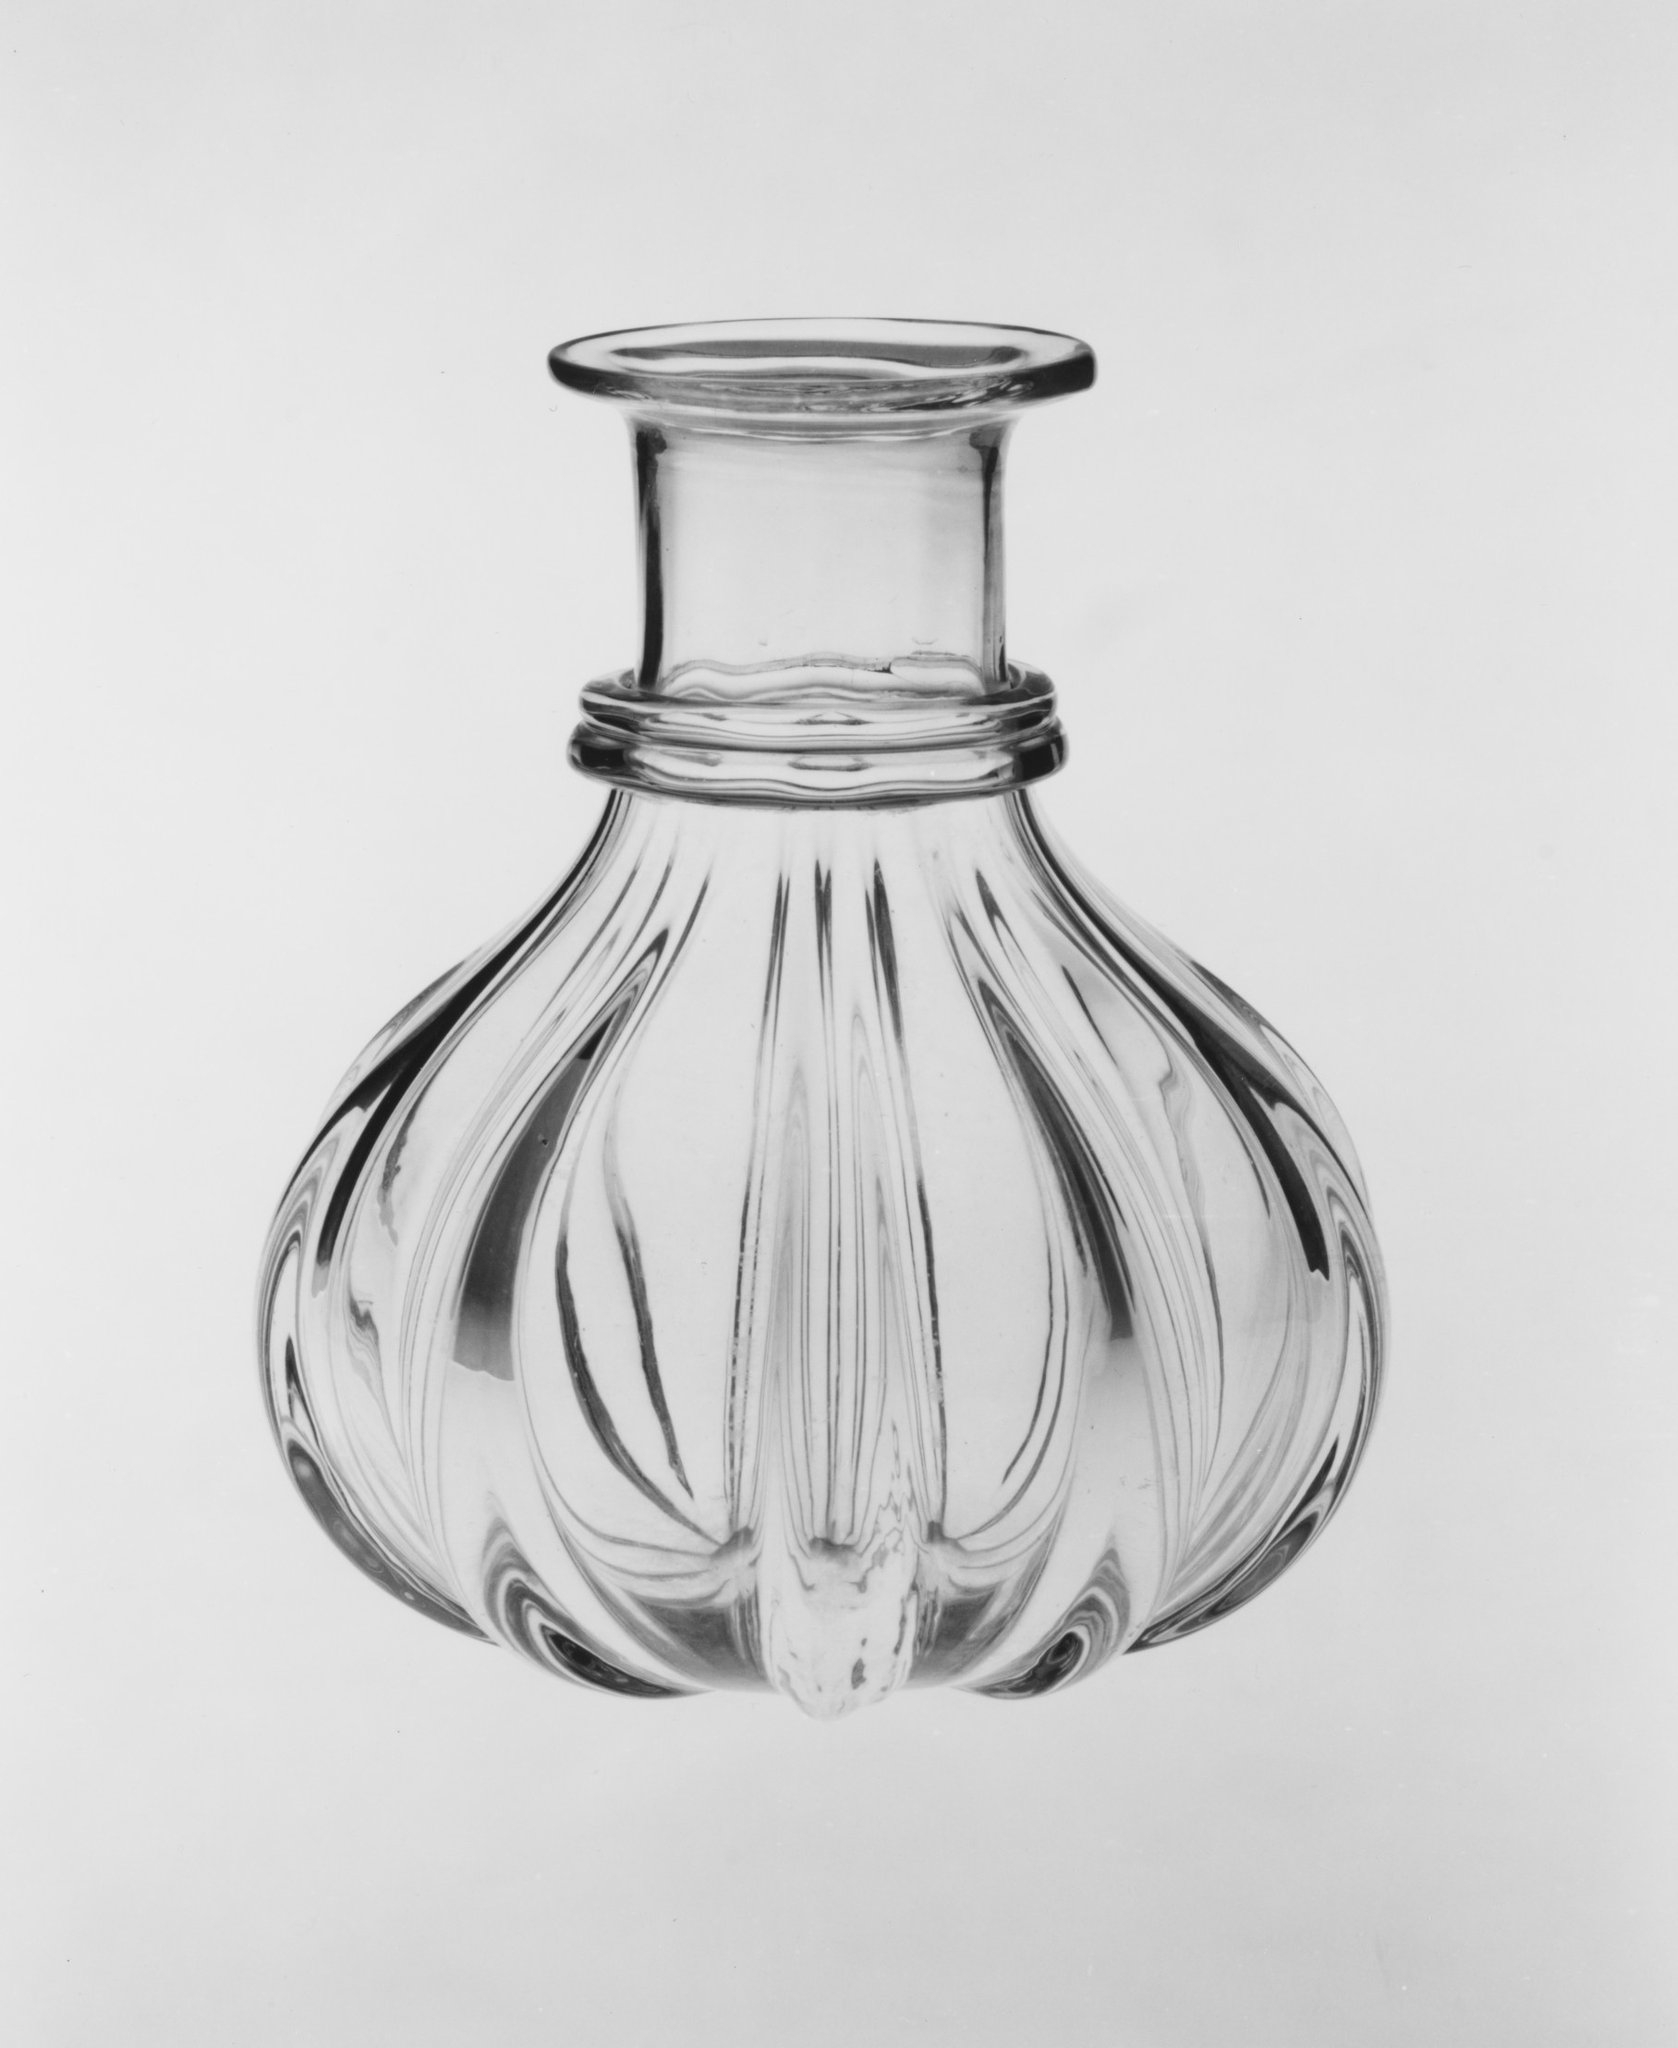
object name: carafe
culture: american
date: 1850-1870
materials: glass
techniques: glassblowing, molding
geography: united states